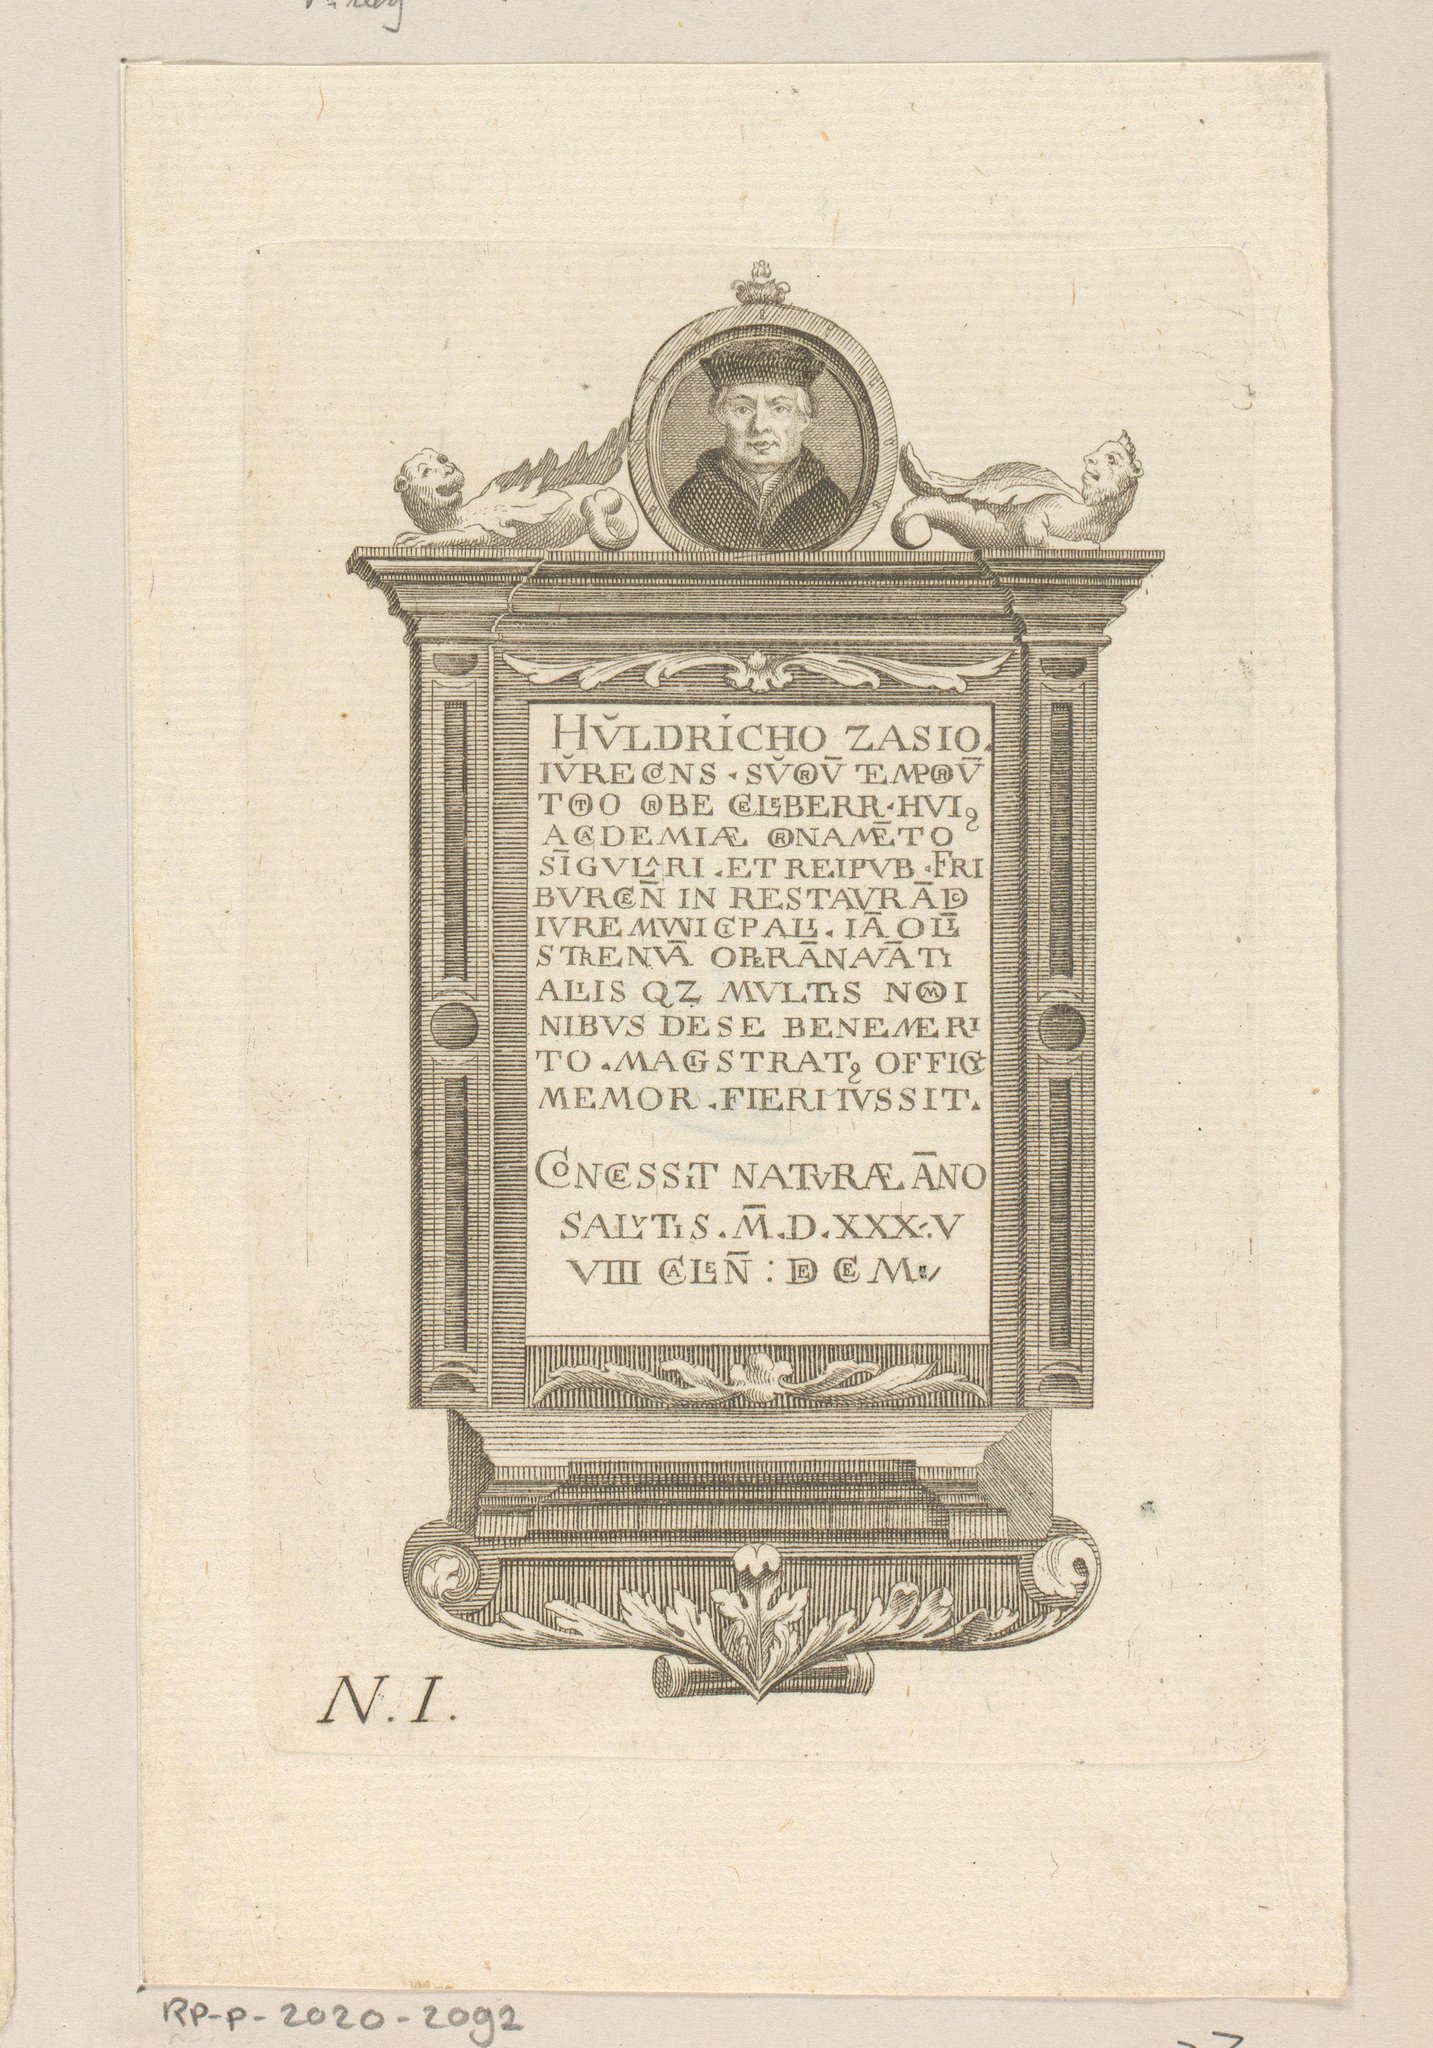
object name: print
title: Huldricho Zasio (...)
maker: Anonymous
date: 1770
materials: paper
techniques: engraving, etching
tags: historical persons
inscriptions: collector's mark: Lugt 2228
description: Prent voor het eerst verschenen in: Riegger, Joseph Anton. Uldalrici Zasii (...) epistolae ad viros aetatis suae doctissimos. Freiburg: Anton Wagner en Zonen, 1770. Prent opnieuw verschenen in de tweede editie: Riegger, Joseph Anton. Udalrici Zasii (...) epistolae ad viros aetatis suae doctissimos. Ulm: August Lebrecht Stettin, 1774.